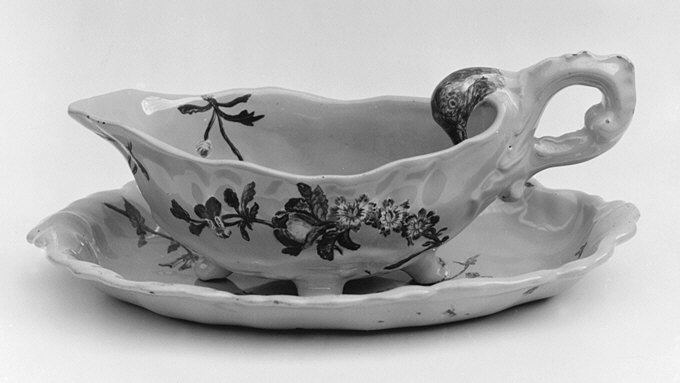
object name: sauceboat tray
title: Sauceboat and tray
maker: veuve perrin factory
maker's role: factory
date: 1760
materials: faience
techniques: glazing